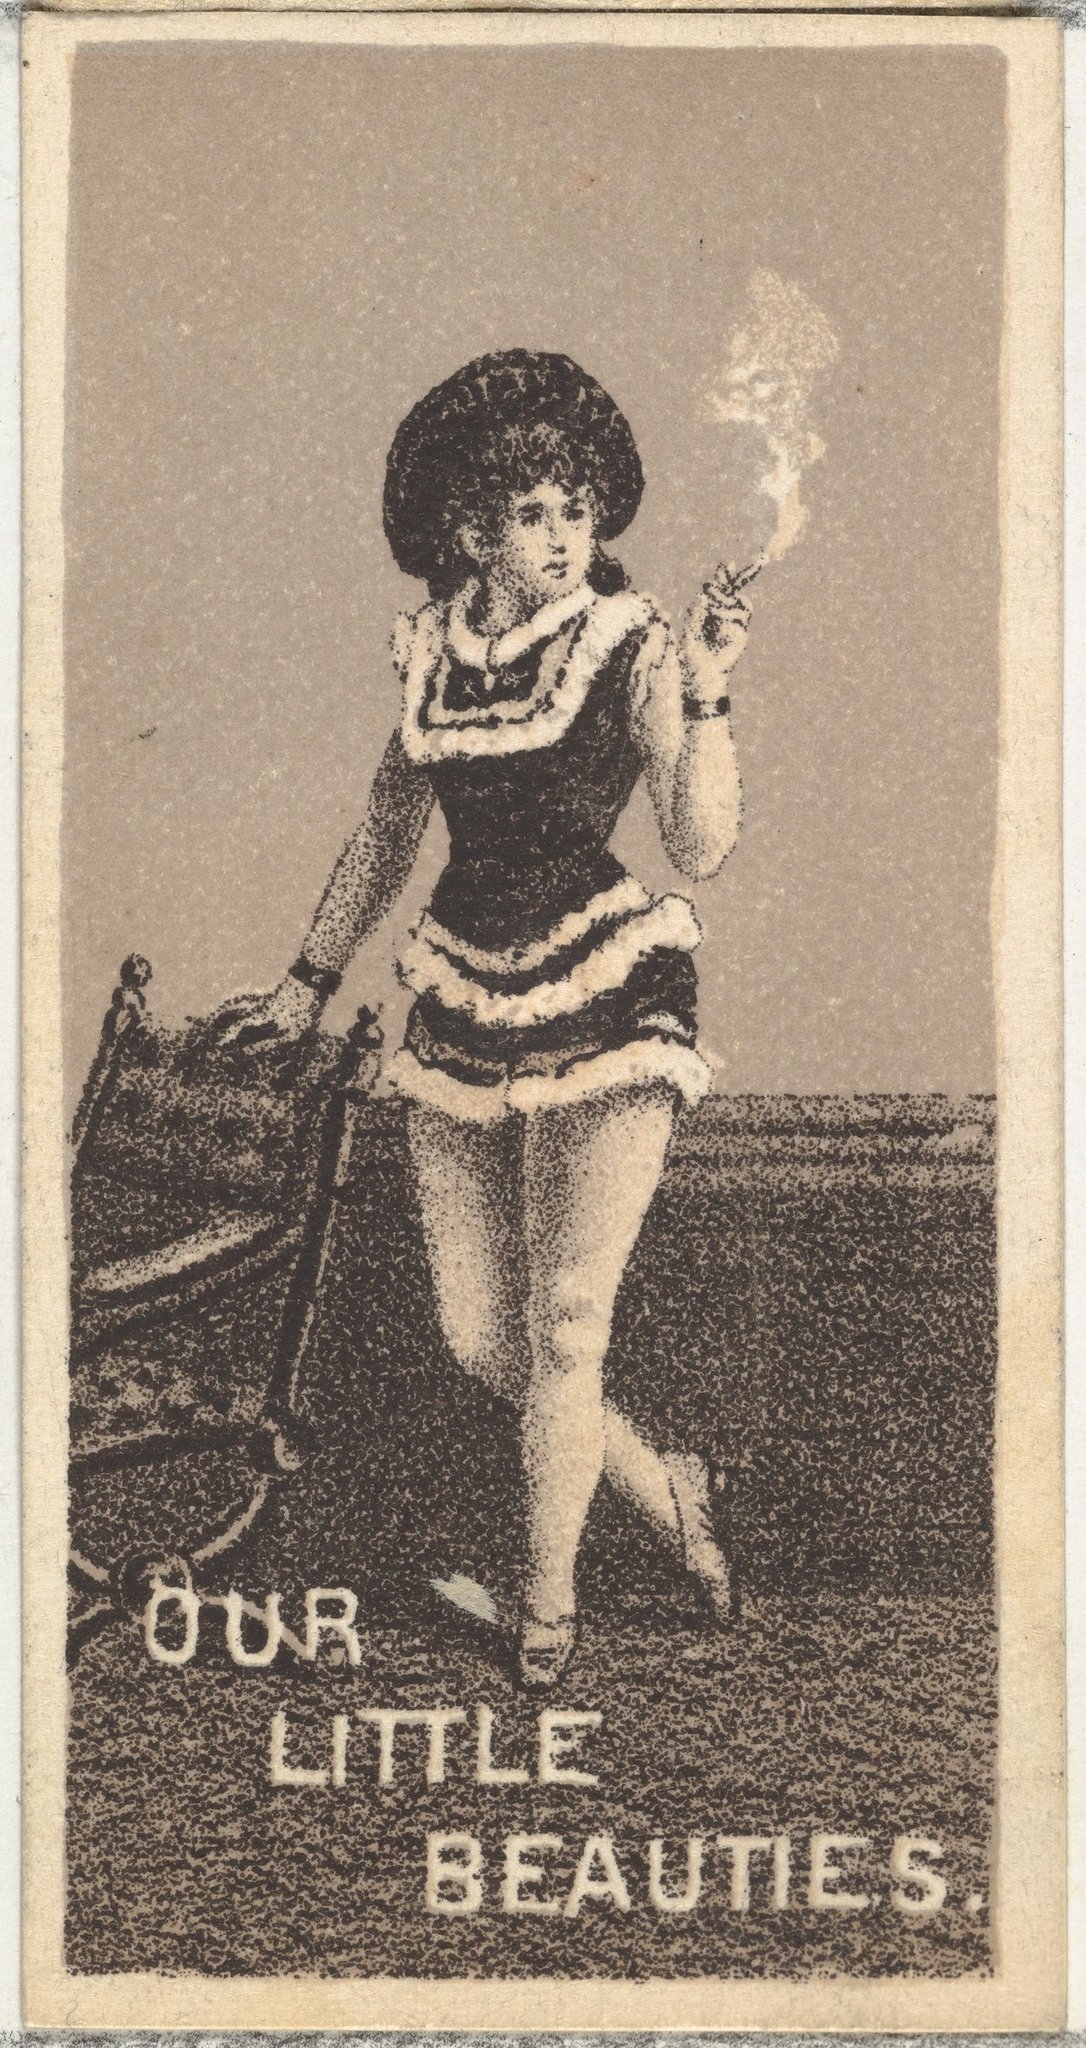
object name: print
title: From the Actresses series (N57) promoting Our Little Beauties Cigarettes for Allen & Ginter brand tobacco products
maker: allen & ginter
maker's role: publisher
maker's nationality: american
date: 1890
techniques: photolithograph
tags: portraits,women,smoking